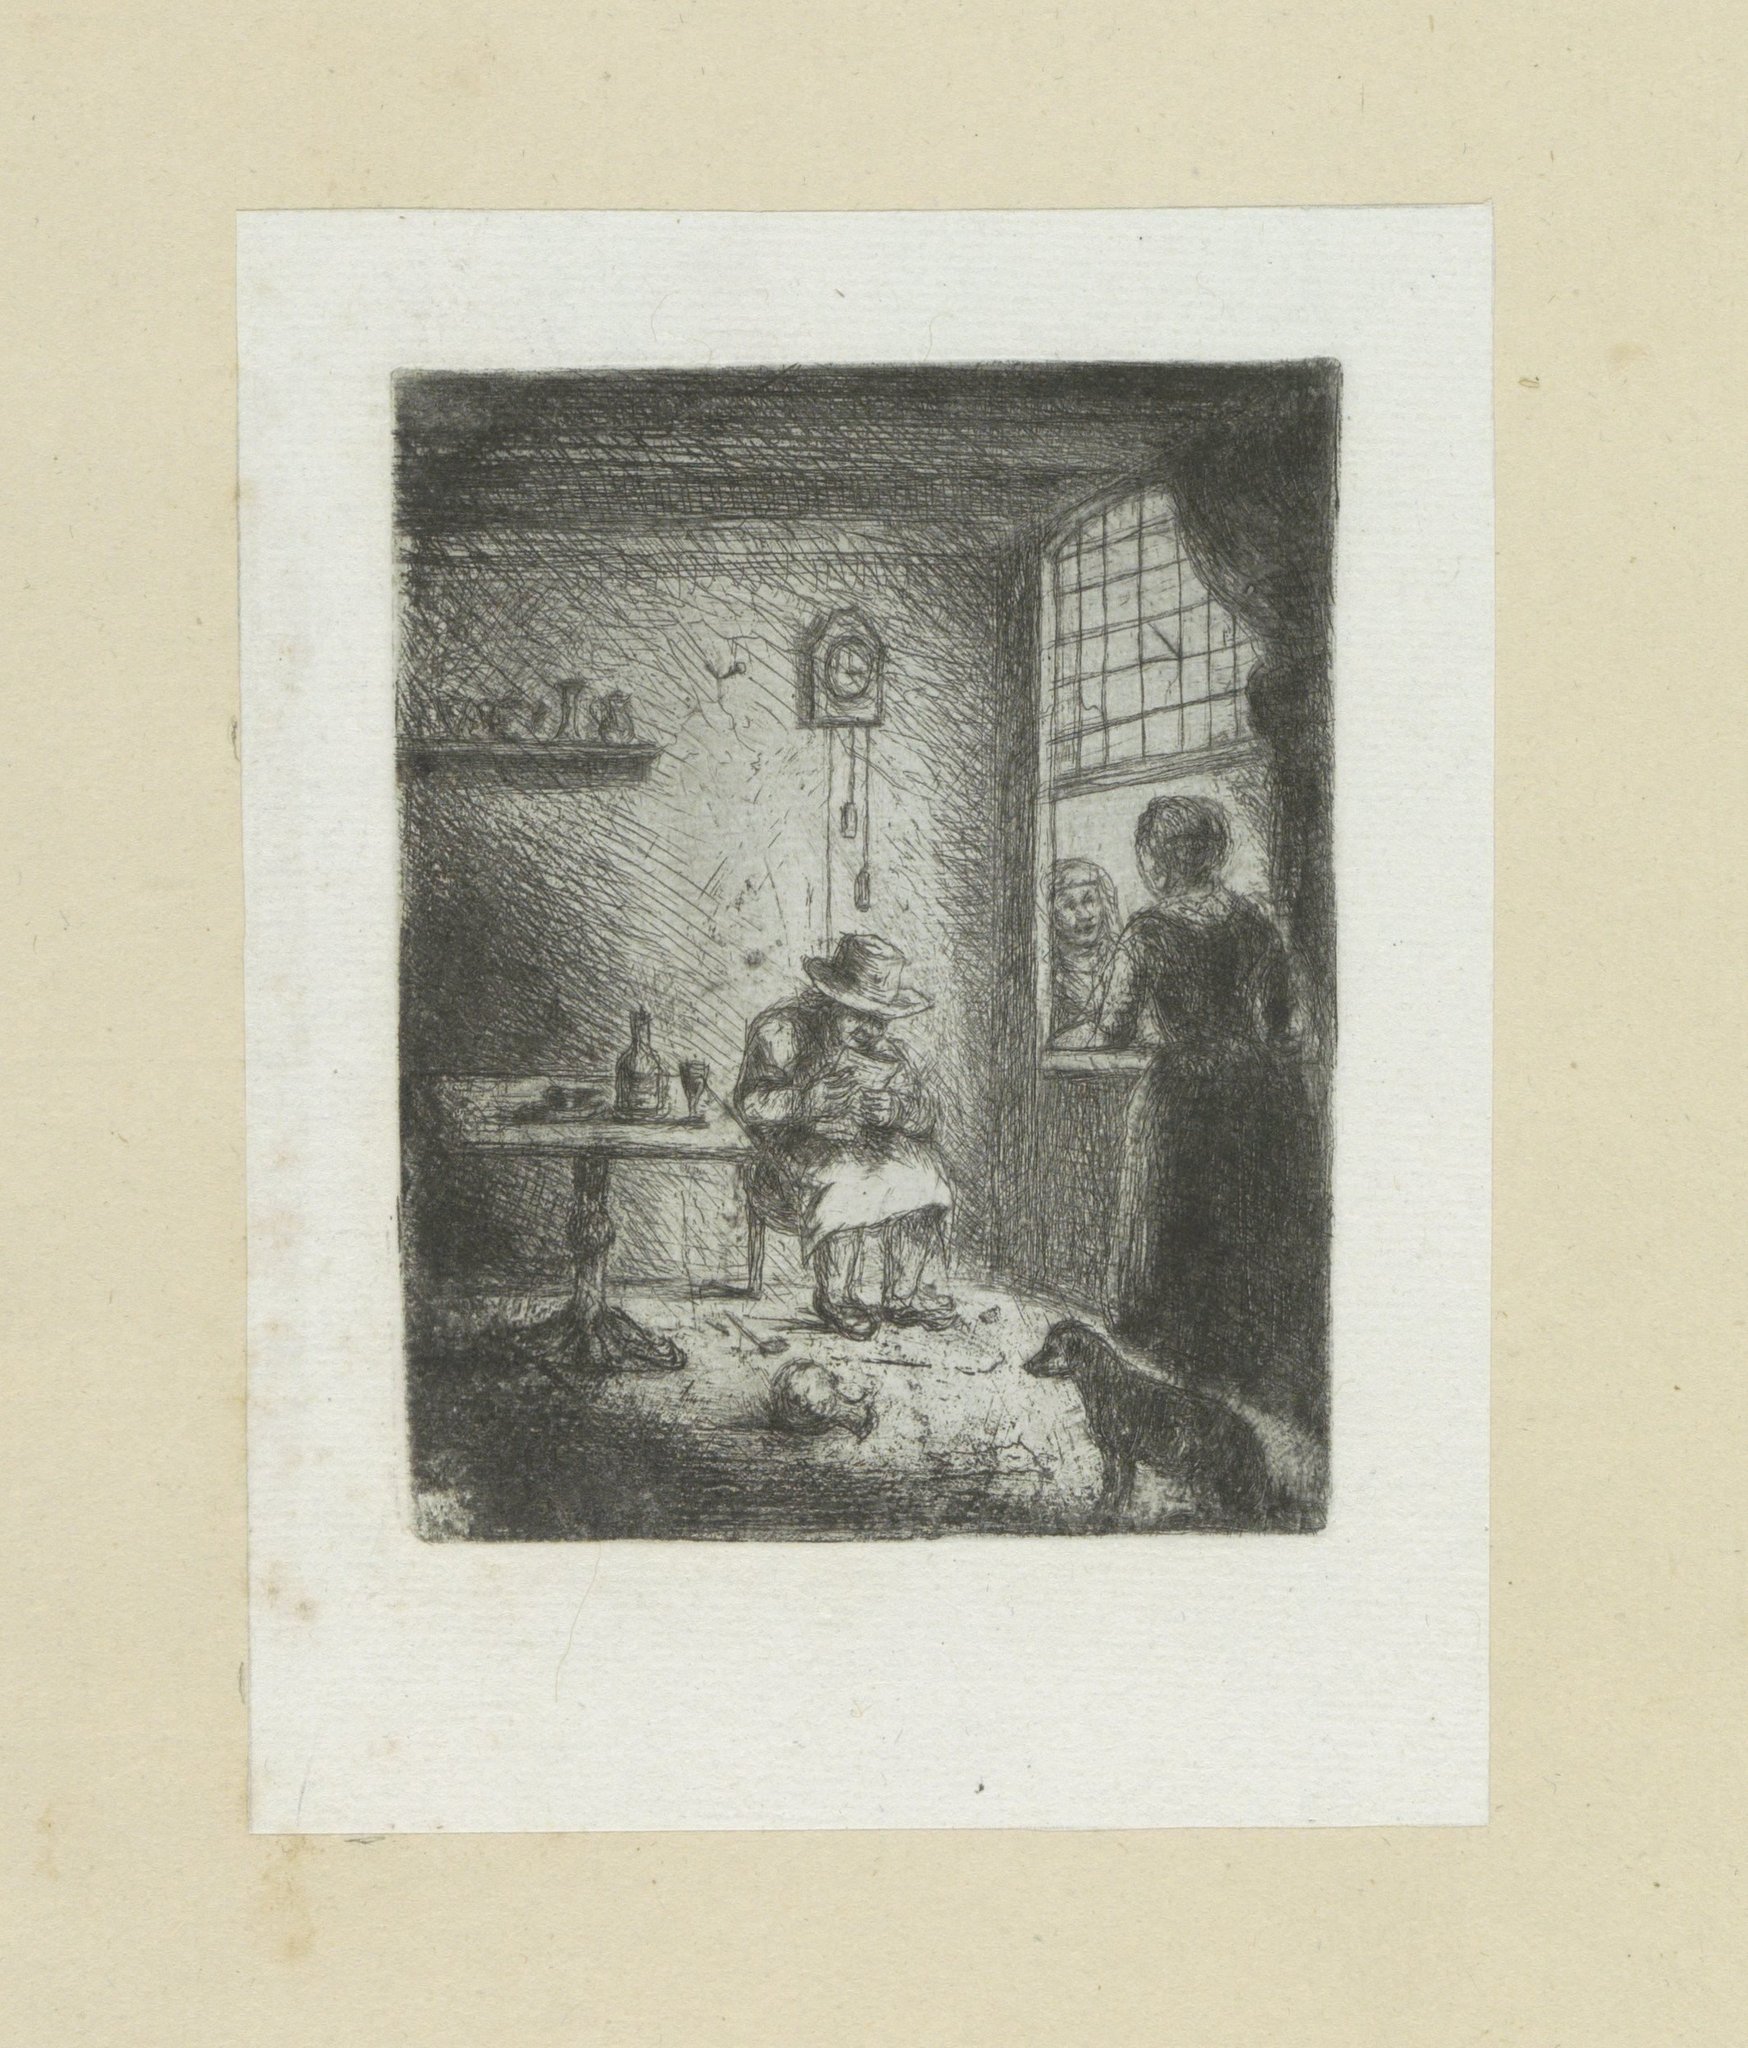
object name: print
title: The Compleat Work of Etchings by John Chalon / Oeuvre Complette des Eaux Fortes par Jean Chalon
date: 1802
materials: paper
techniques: drypoint, etching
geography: london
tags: reading, pamphlet ~ printed matter, living-room, parlour, sitting-room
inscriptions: collector's mark: ‘B’, collector's mark: ‘RIJKS / MUSM’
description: Interieur van een huis. Een man zit op een stoel onder een wandklok en leest. Twee vrouwen praten met elkaar door een open raam. Een hond op de voorgrond. De prent maakt deel uit van een album.